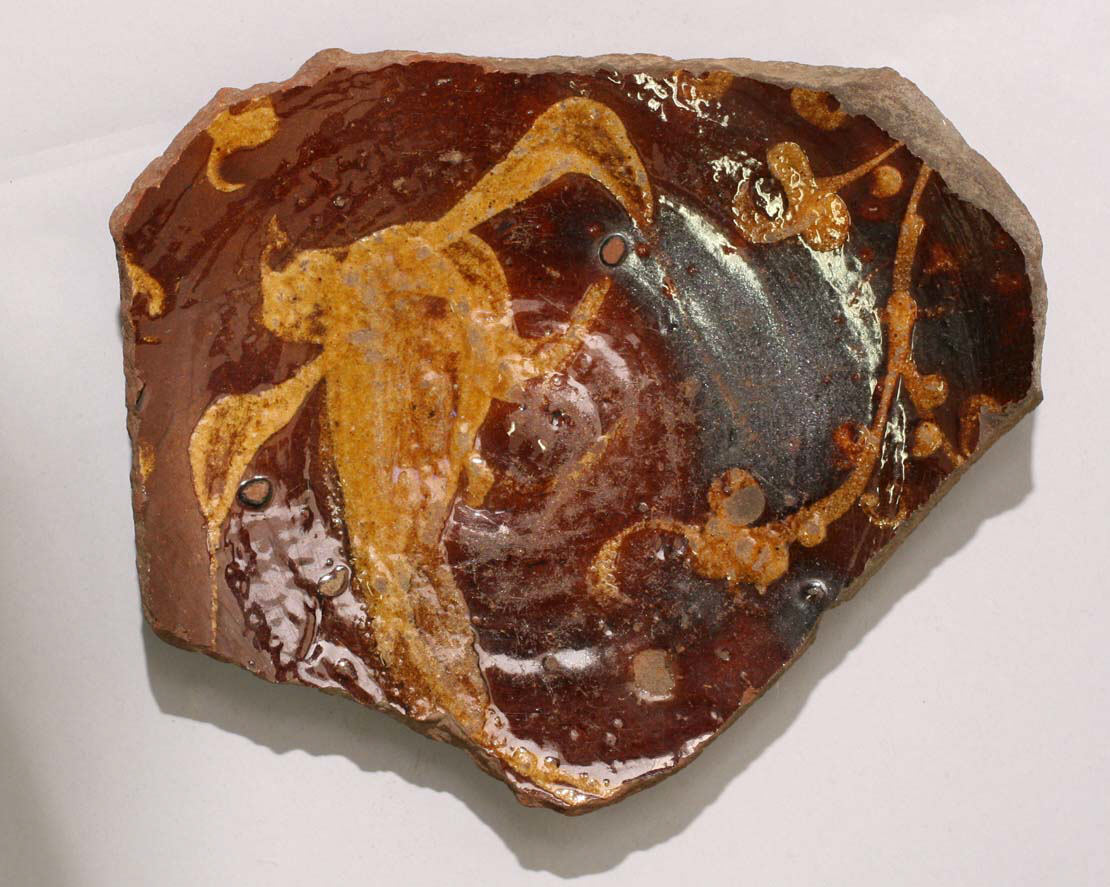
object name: fragment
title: Ceramic Fragment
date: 1301-1500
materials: earthenware, glaze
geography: egypt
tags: birds